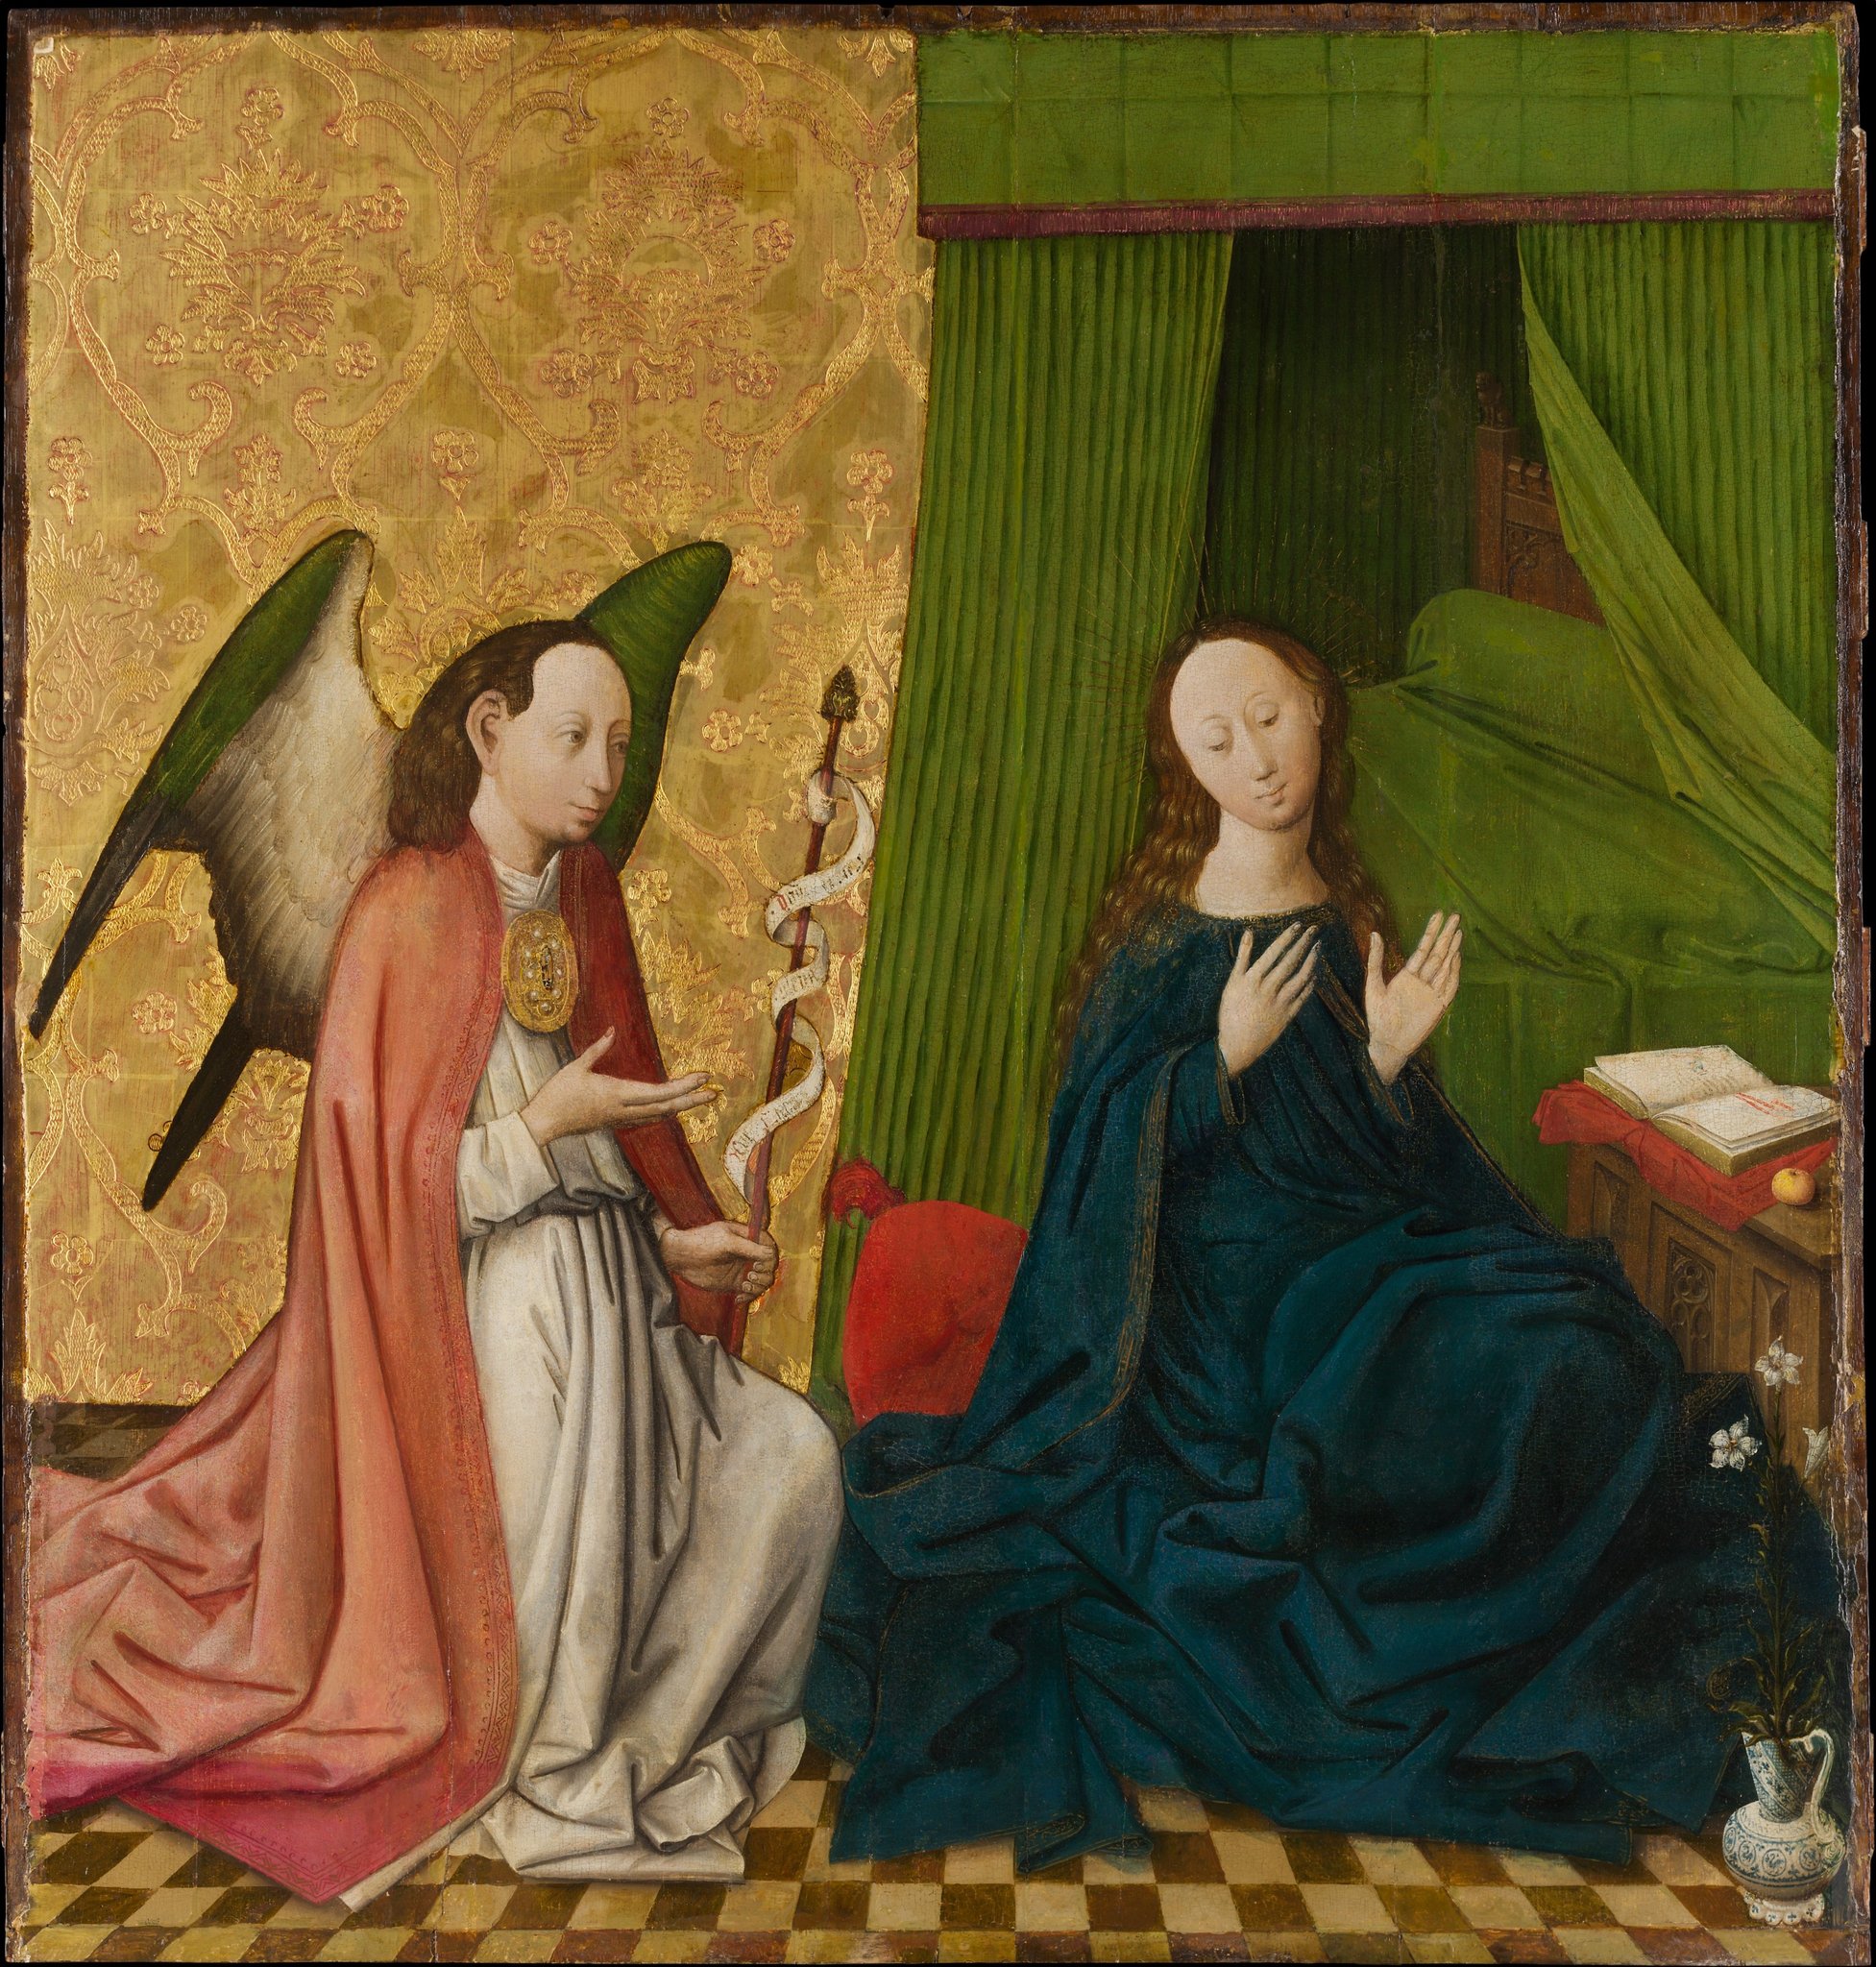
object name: painting, part of an altarpiece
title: The Annunciation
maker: south netherlandish painter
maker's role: artist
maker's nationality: netherlandish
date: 1455-1465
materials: gold leaf, oil, wood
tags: virgin mary,archangel gabriel,annunciation,beds